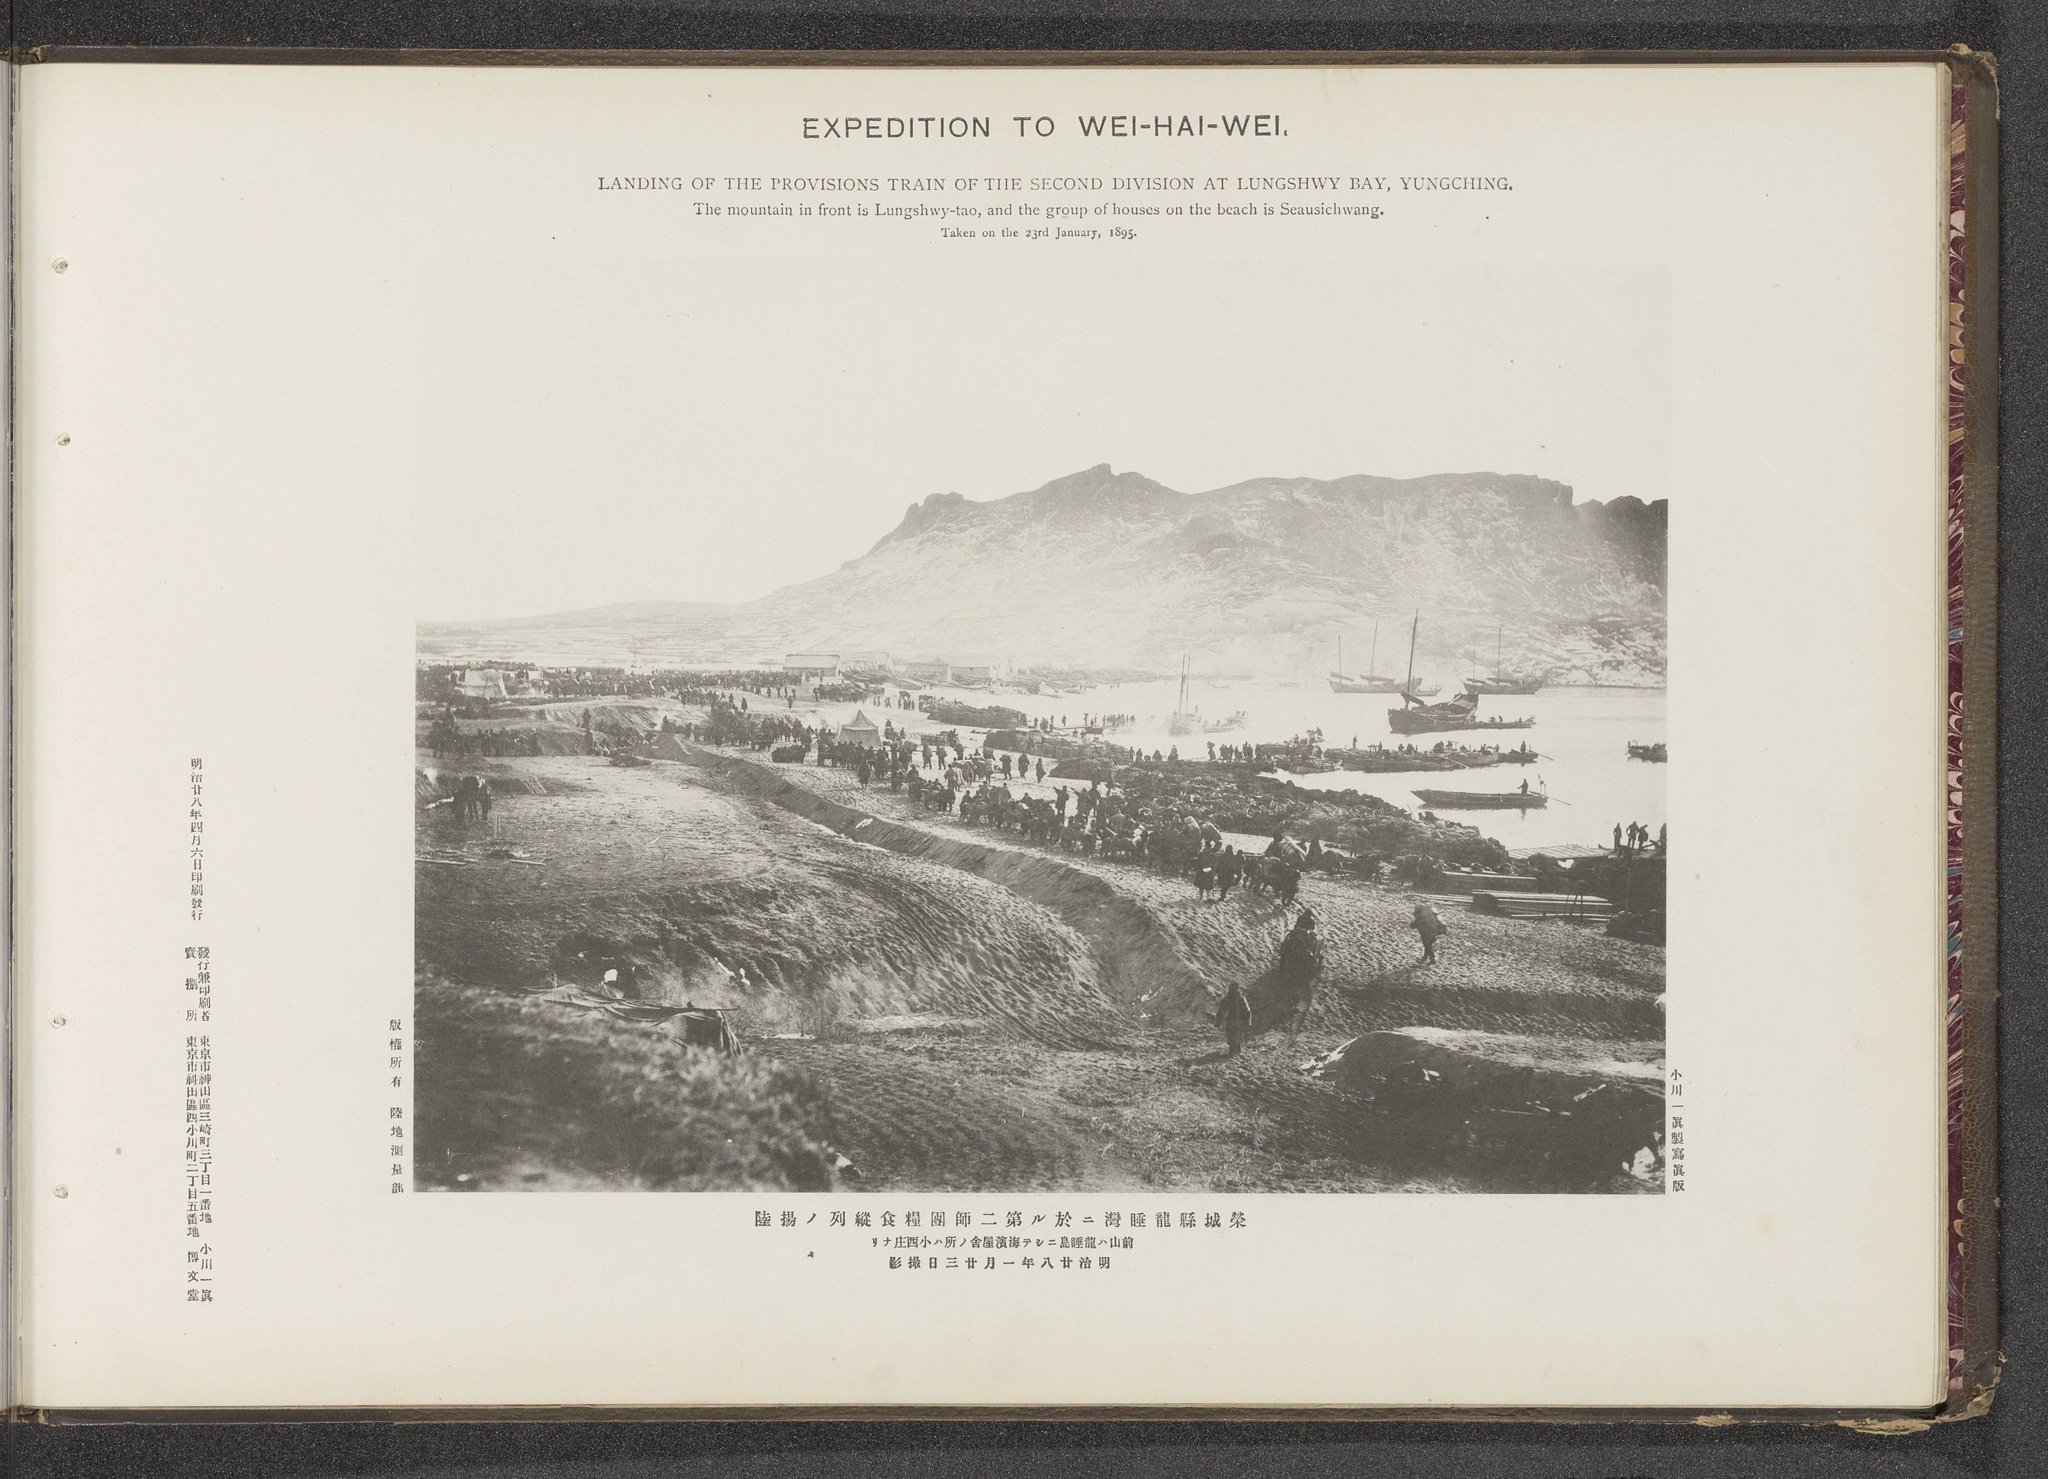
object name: photomechanical print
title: Landing of the provisions train of the second division at Lungshwy bay, Yungching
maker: kazumasa ogawa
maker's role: auteur, fotograaf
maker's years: 1860-1929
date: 1895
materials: paper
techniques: photograph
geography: japan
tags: gulf, bay, troop movements, transportation, hygienic and medical provisions (military), ships (in general)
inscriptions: inscription: ‘Expedition to Wei-hai-wei.’, inscription: ‘The mountain in front is Lungshwy-toa, and the group of houses on the beach is Seausichwang.’